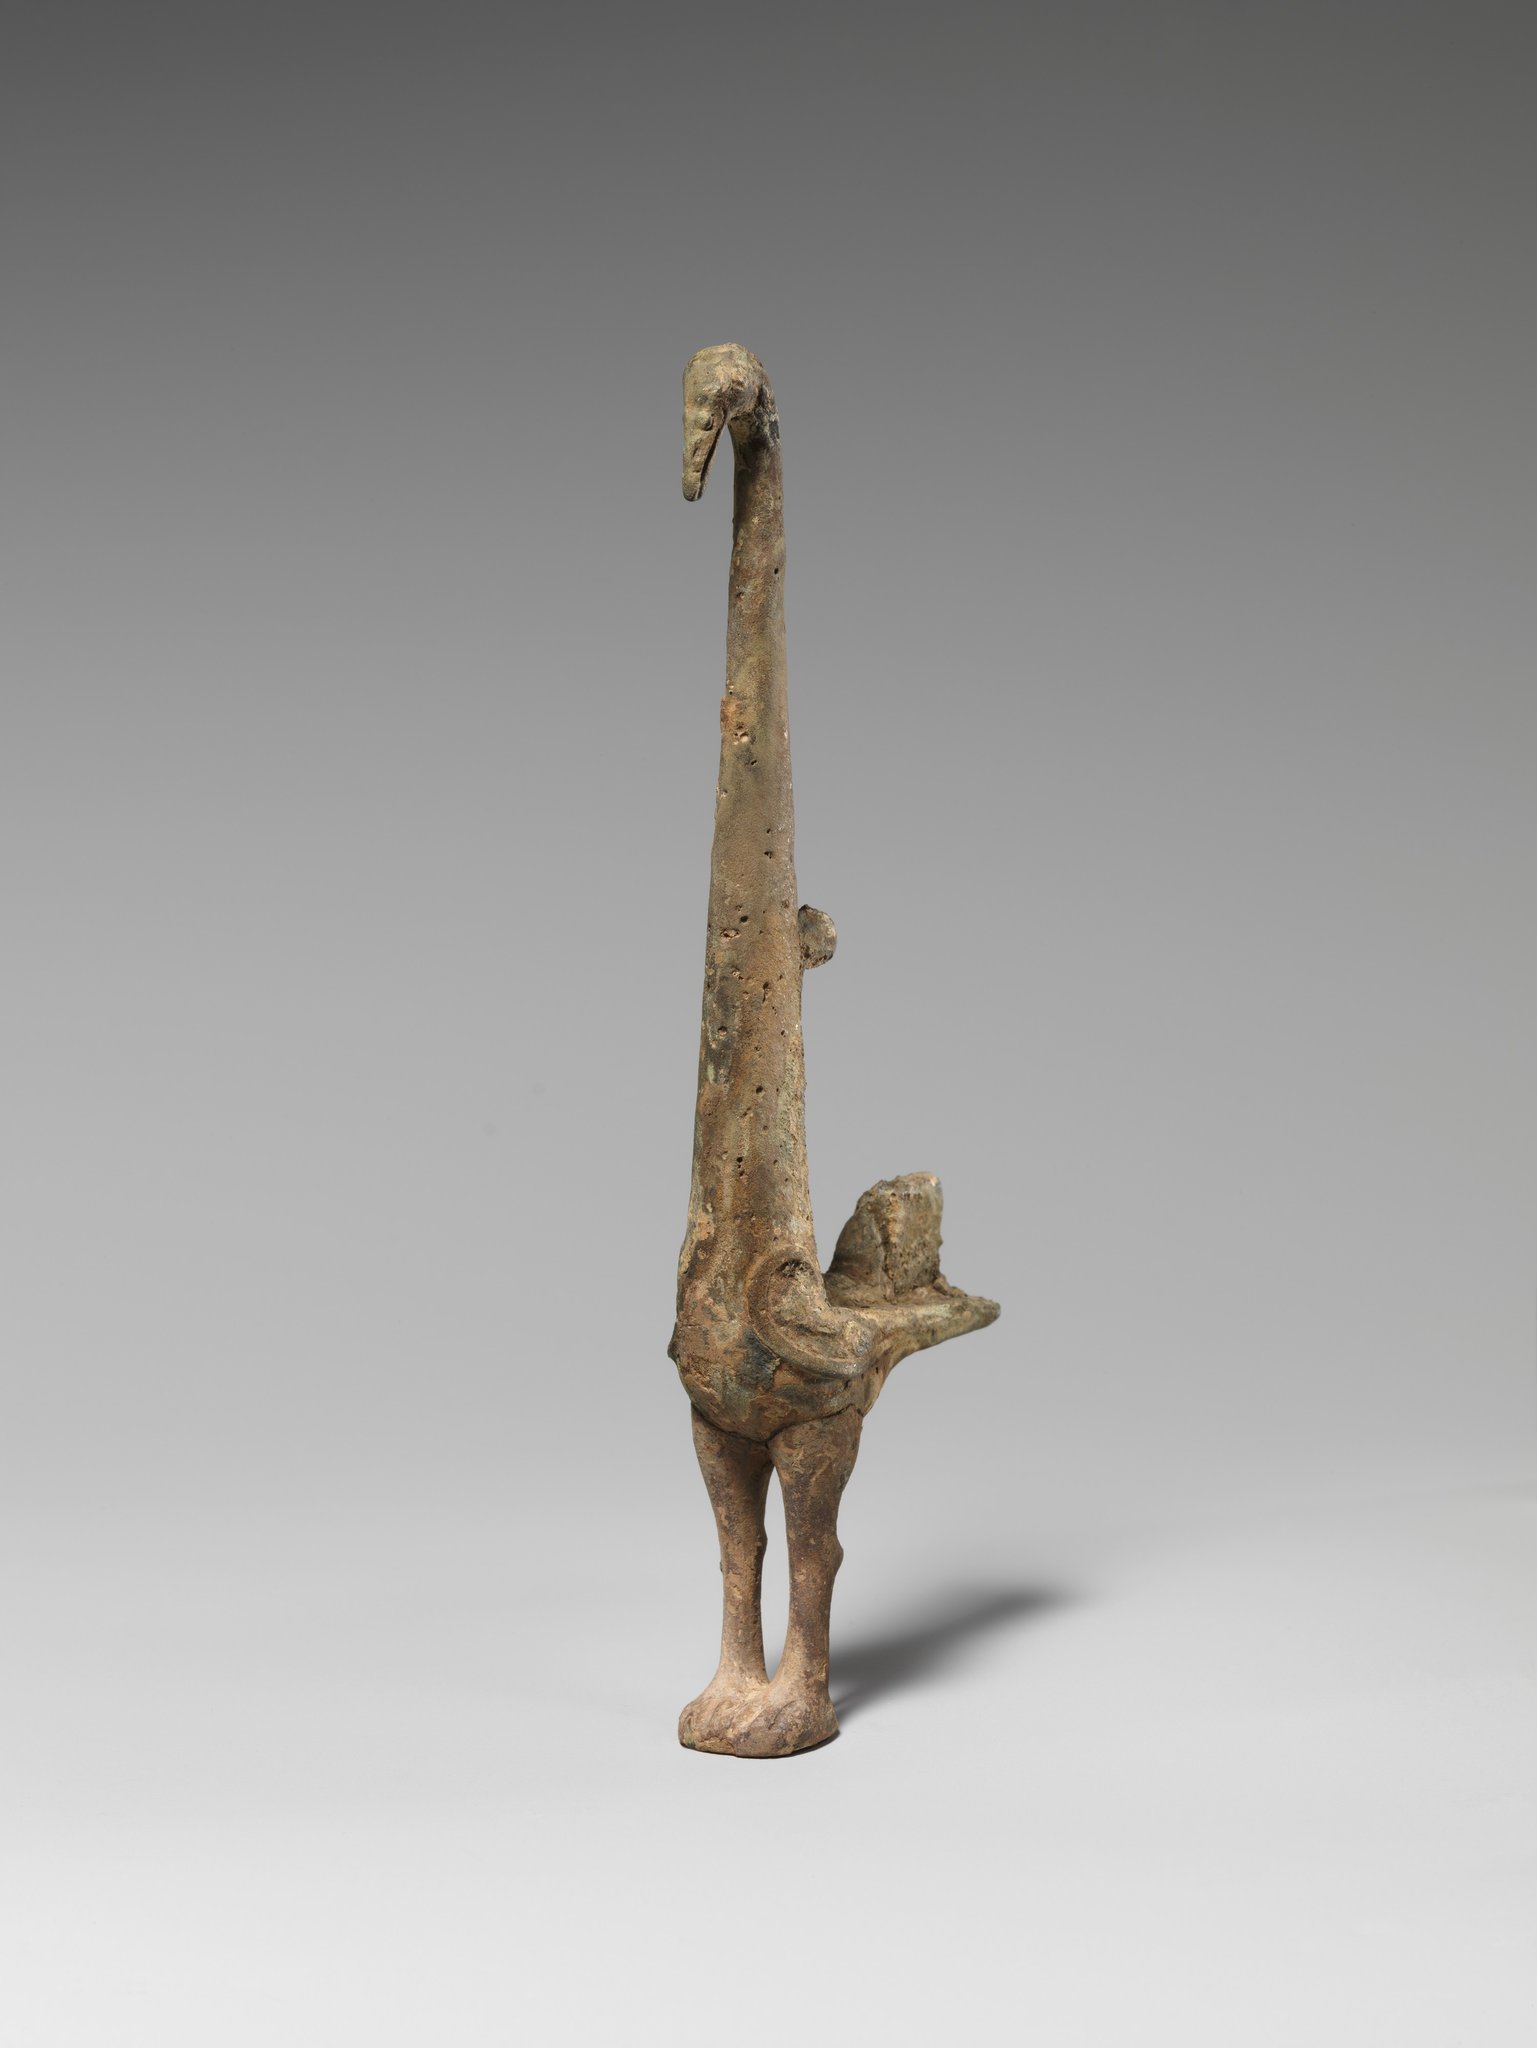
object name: vessel leg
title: Vessel leg in the form of a bird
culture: chinese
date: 500-201 BCE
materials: bronze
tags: birds